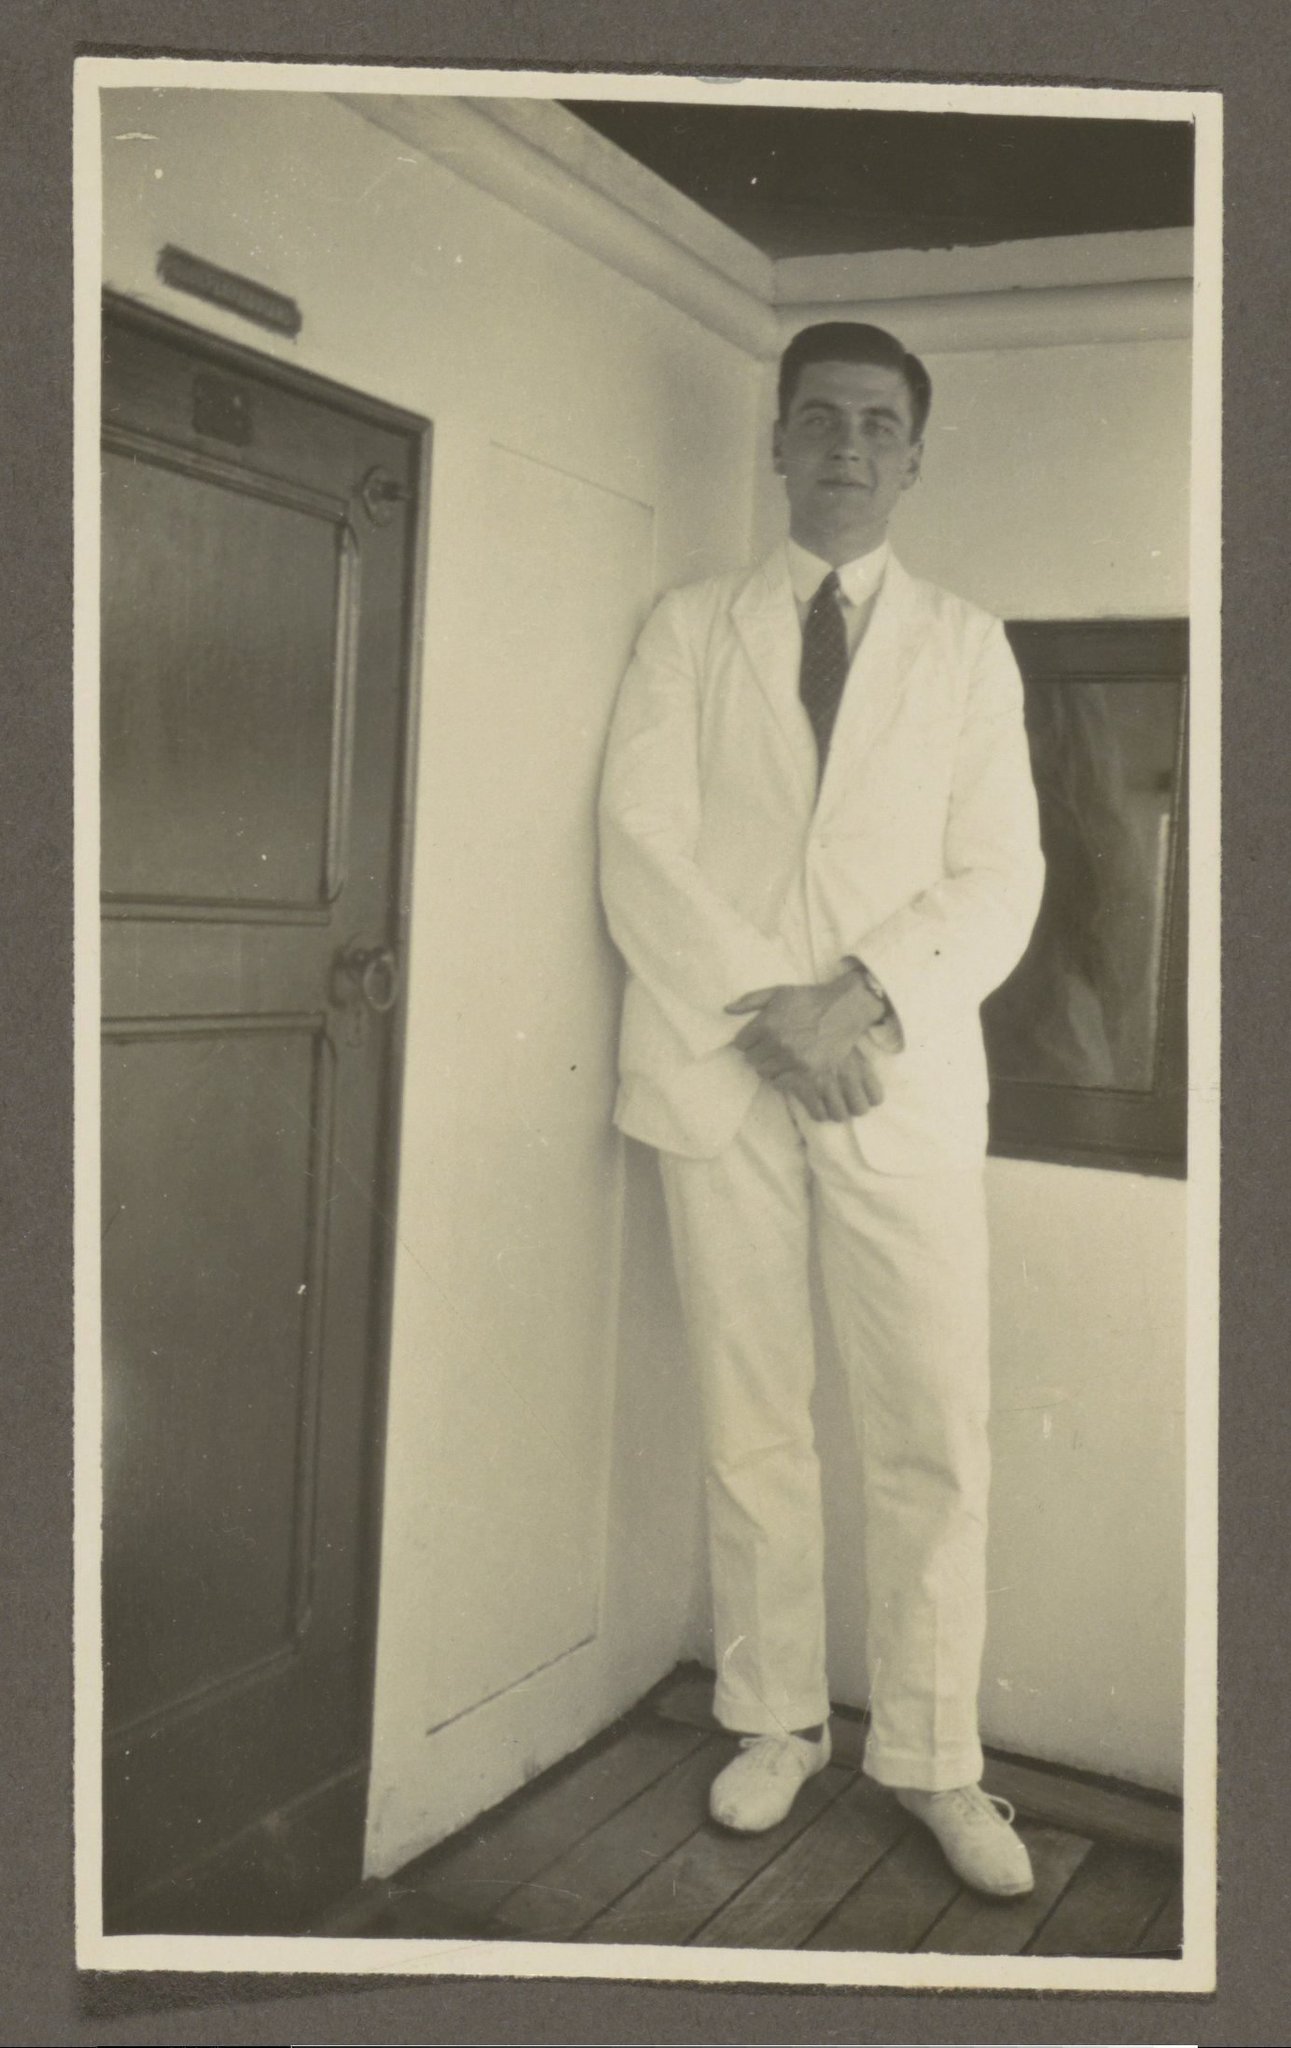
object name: photograph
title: Man poserend in een wit kostuum aan boord van een schip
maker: Anonymous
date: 1920-1930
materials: photographic support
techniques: gelatin silver print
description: Onderdeel van familiealbum Nederlands-Indië.